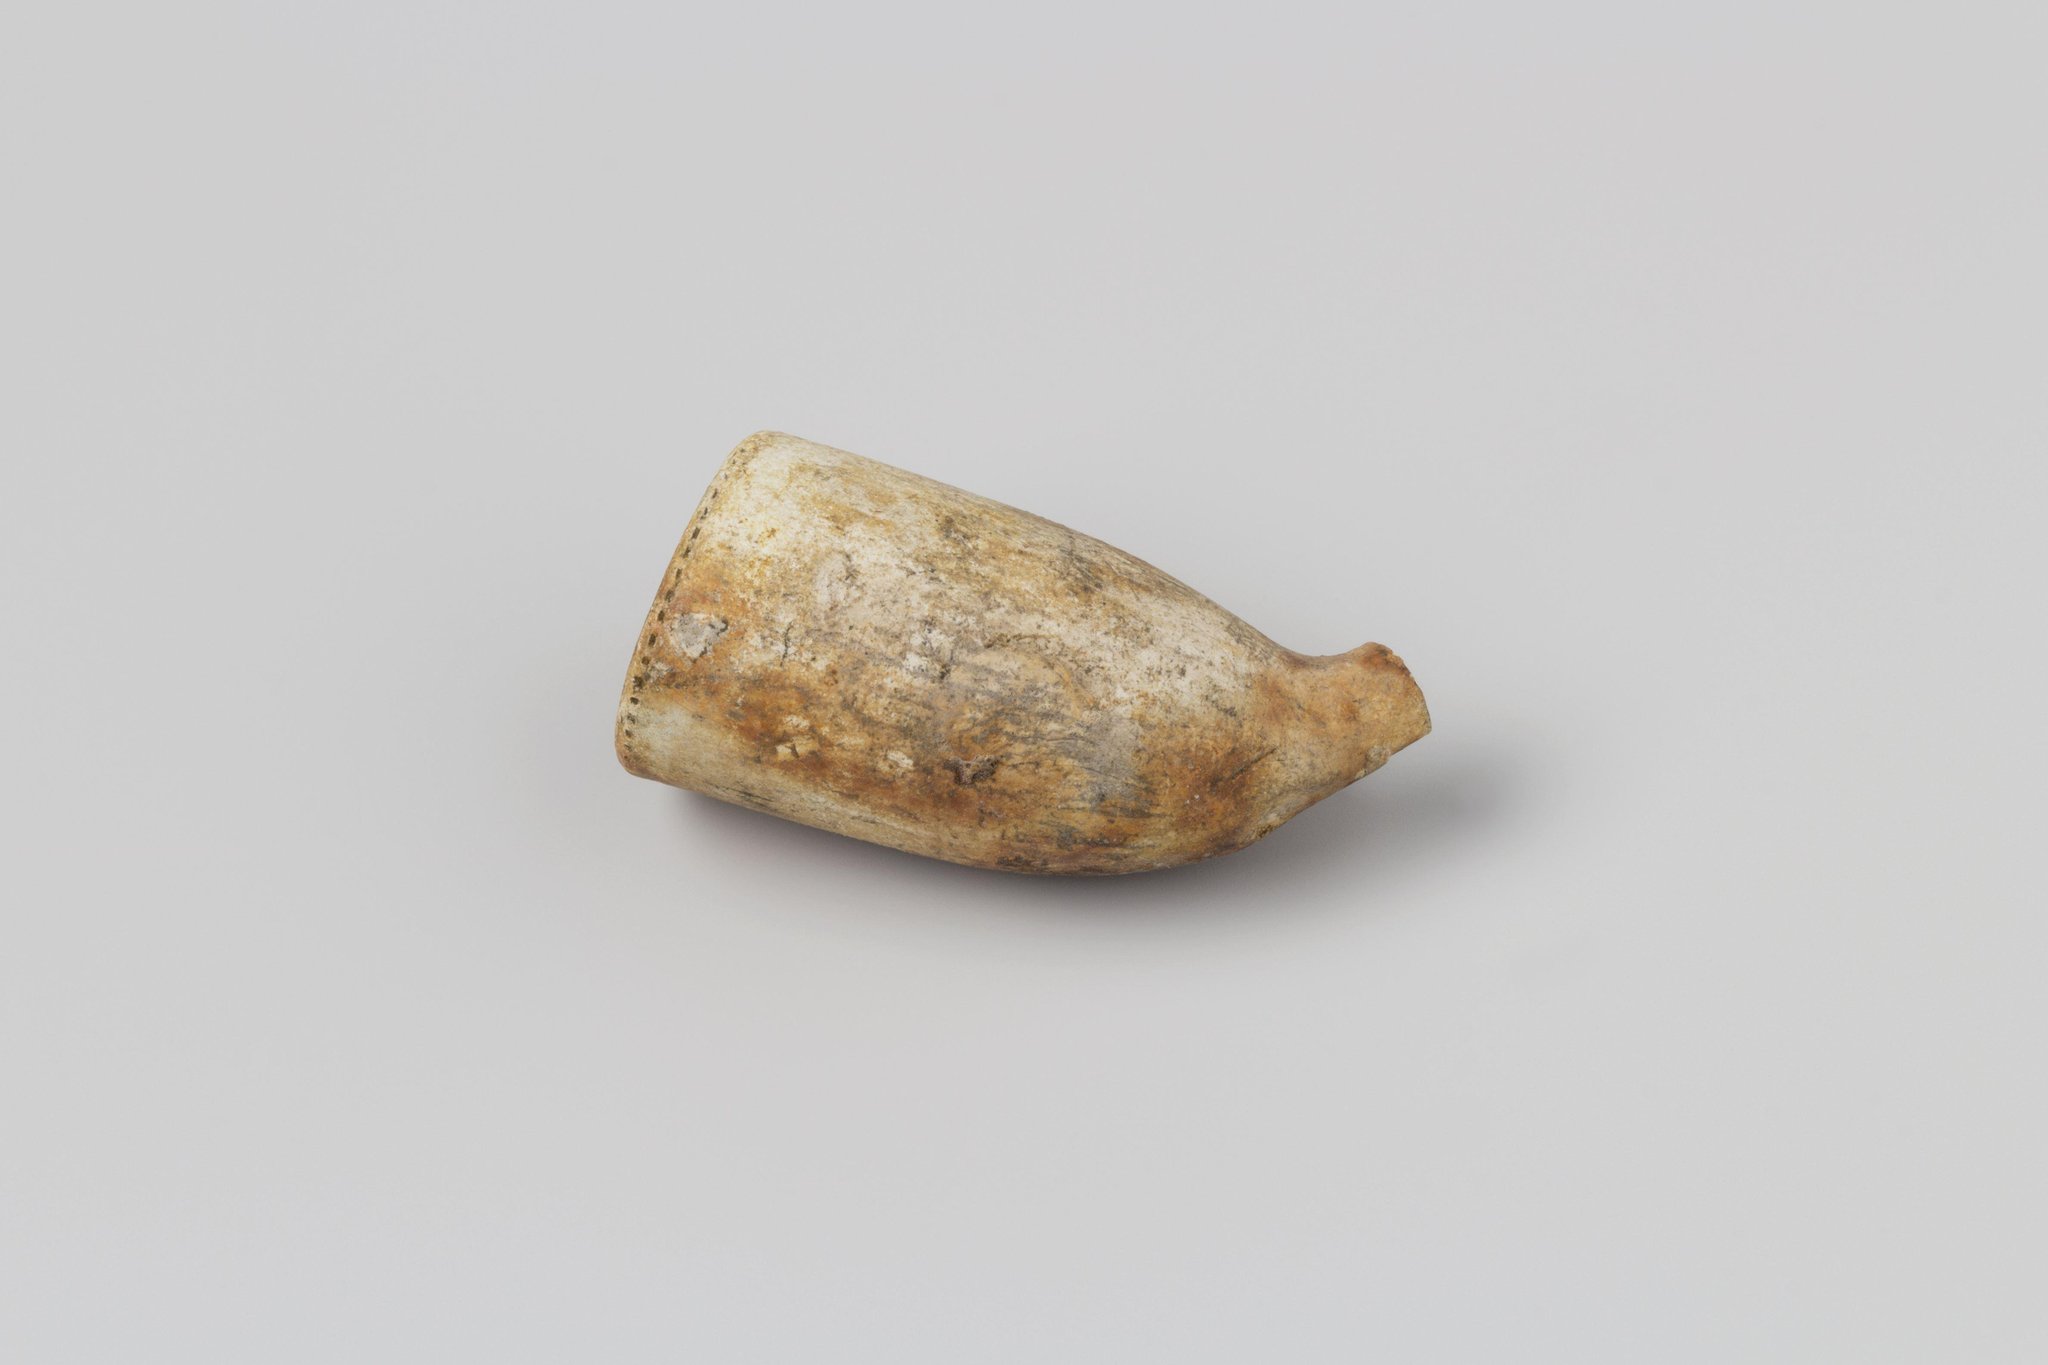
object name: pipe bowl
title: Pijpenkop uit het wrak van de Oost-Indiëvaarder Hollandia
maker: Anonymous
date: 1700-1743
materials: clay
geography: netherlands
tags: verenigde oostindische compagnie, hollandia (schip), annet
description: Pipe, bowl without heel: stamped decoration; imprint illegible.